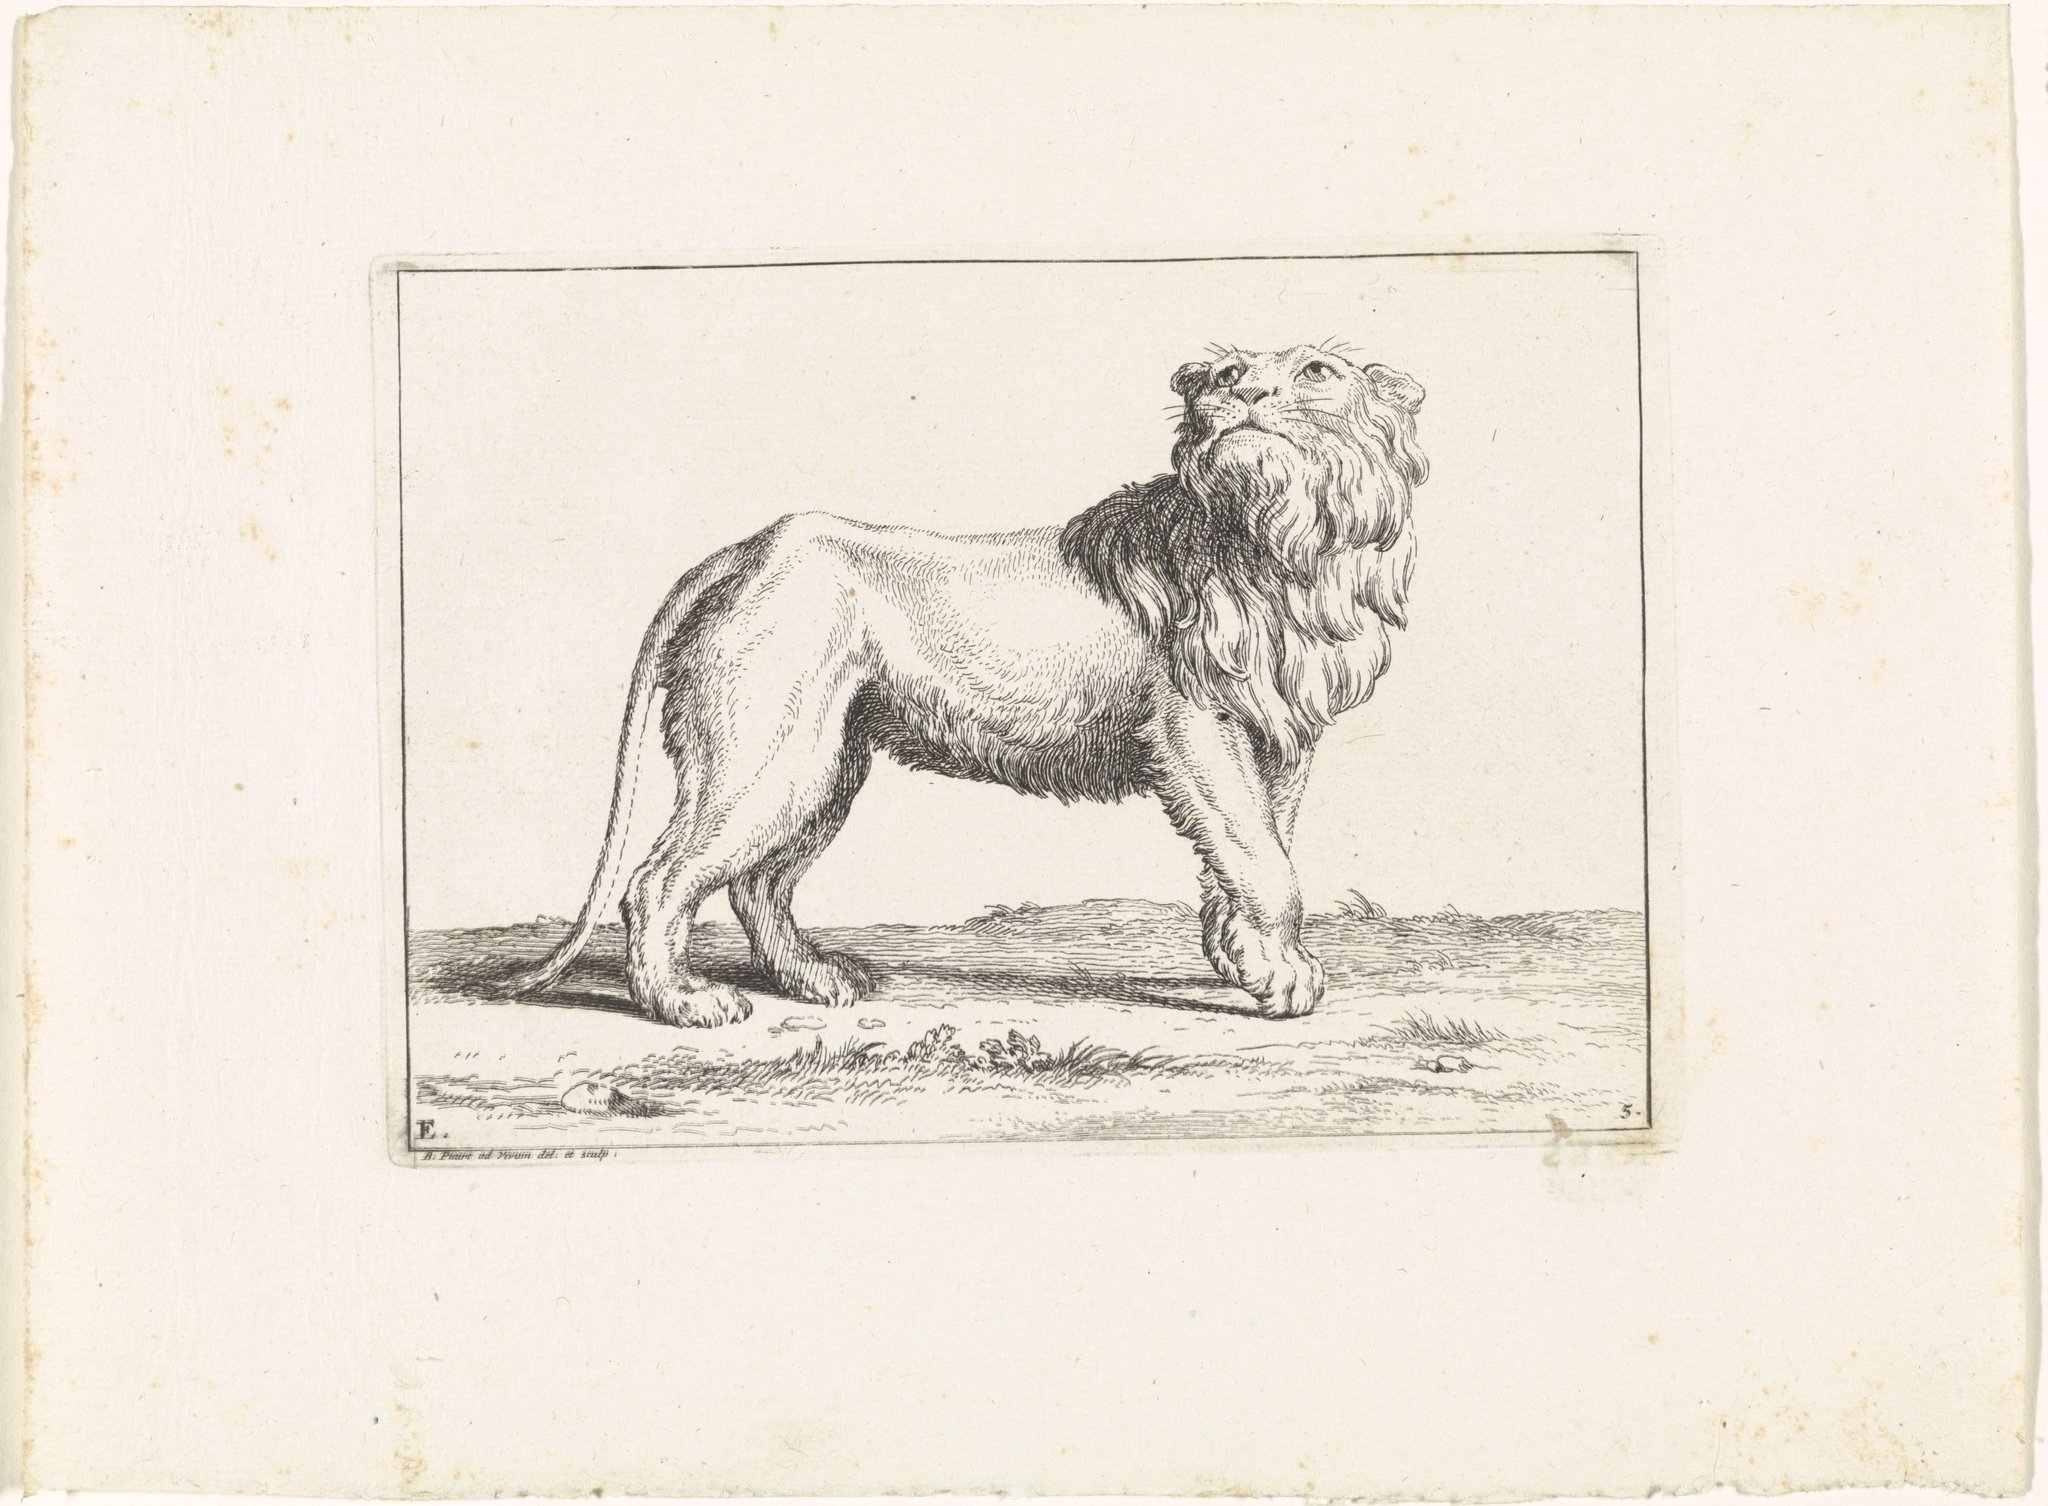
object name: book illustration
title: Leeuw kijkt omhoog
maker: bernard picart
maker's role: draughtsman, print maker, publisher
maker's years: 1673-1733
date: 1729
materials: paper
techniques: etching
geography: amsterdam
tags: beasts of prey, predatory animals: lion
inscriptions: collector's mark: Lugt 2165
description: Prent ook als illustratie gebruikt in: Recueil de lions, dessinez d'après nature par divers maitres. Amsterdam: Bernard Picart, 1729.